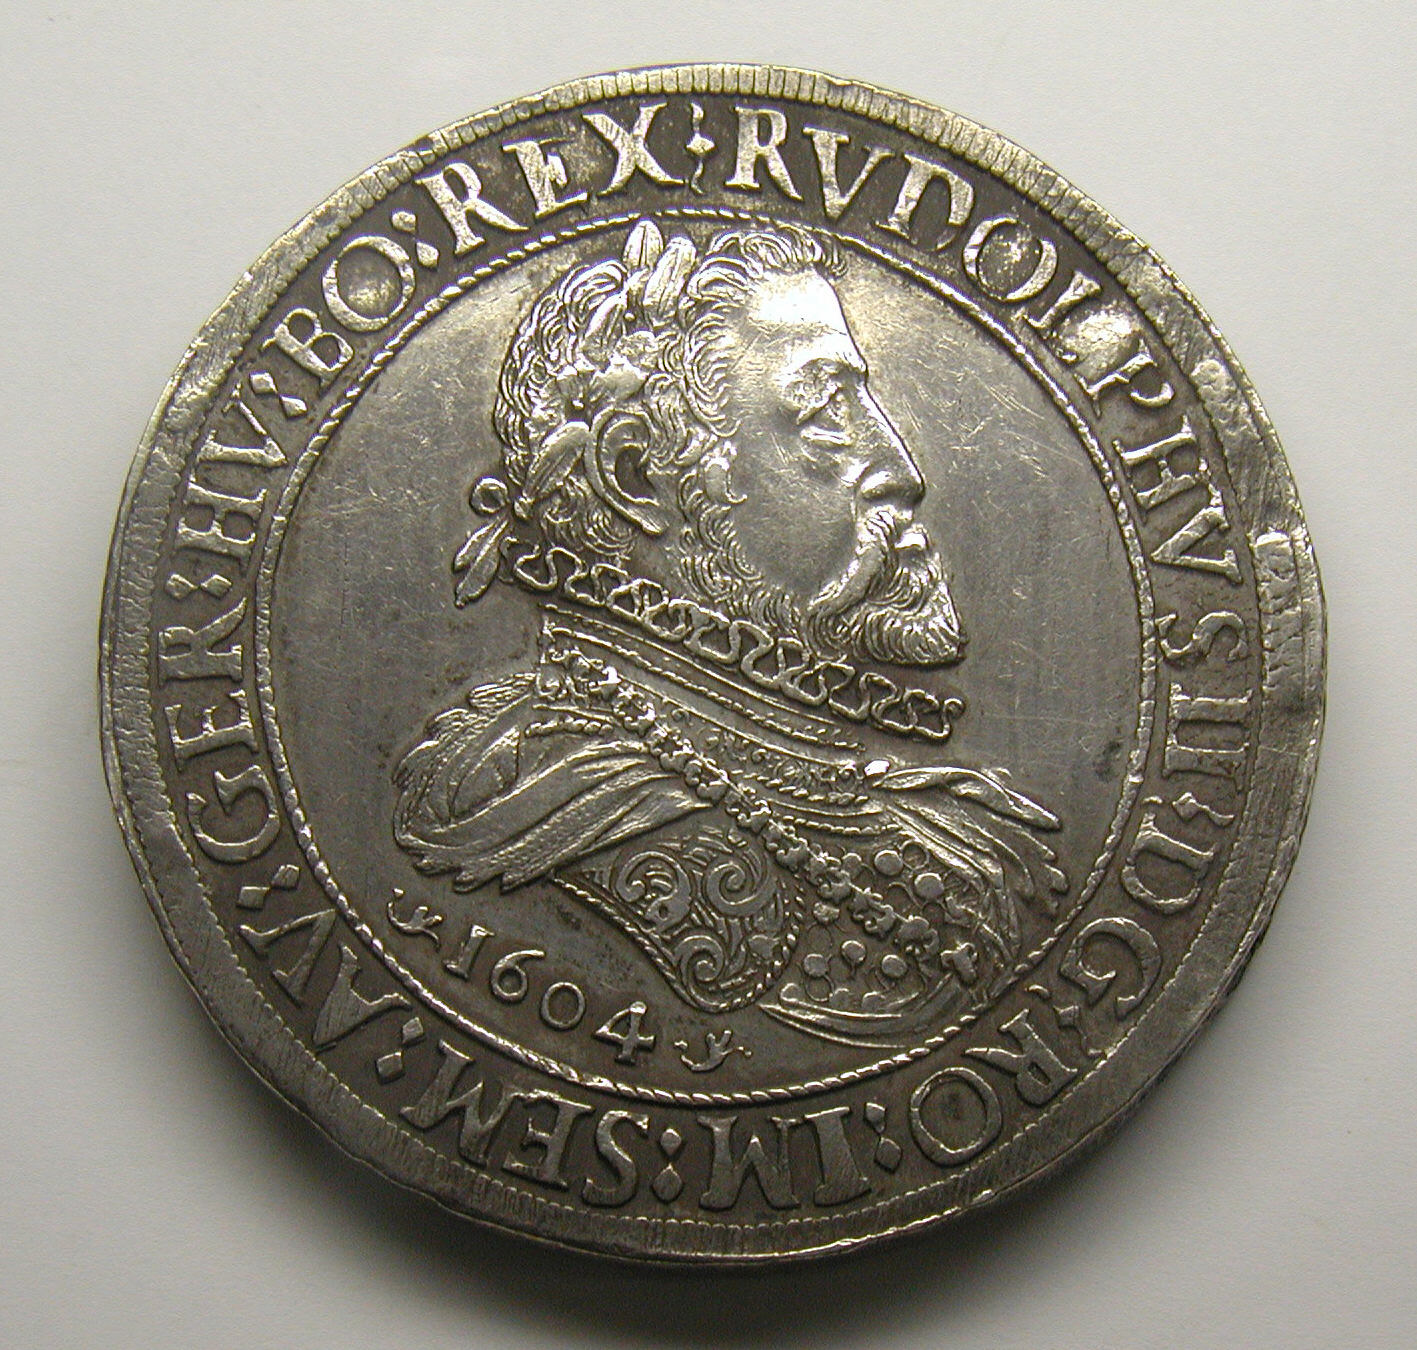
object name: thaler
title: Rudolph II (1552–1612), Emperor of the Holy Roman Empire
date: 1604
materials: silver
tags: kings,profiles,coat of arms